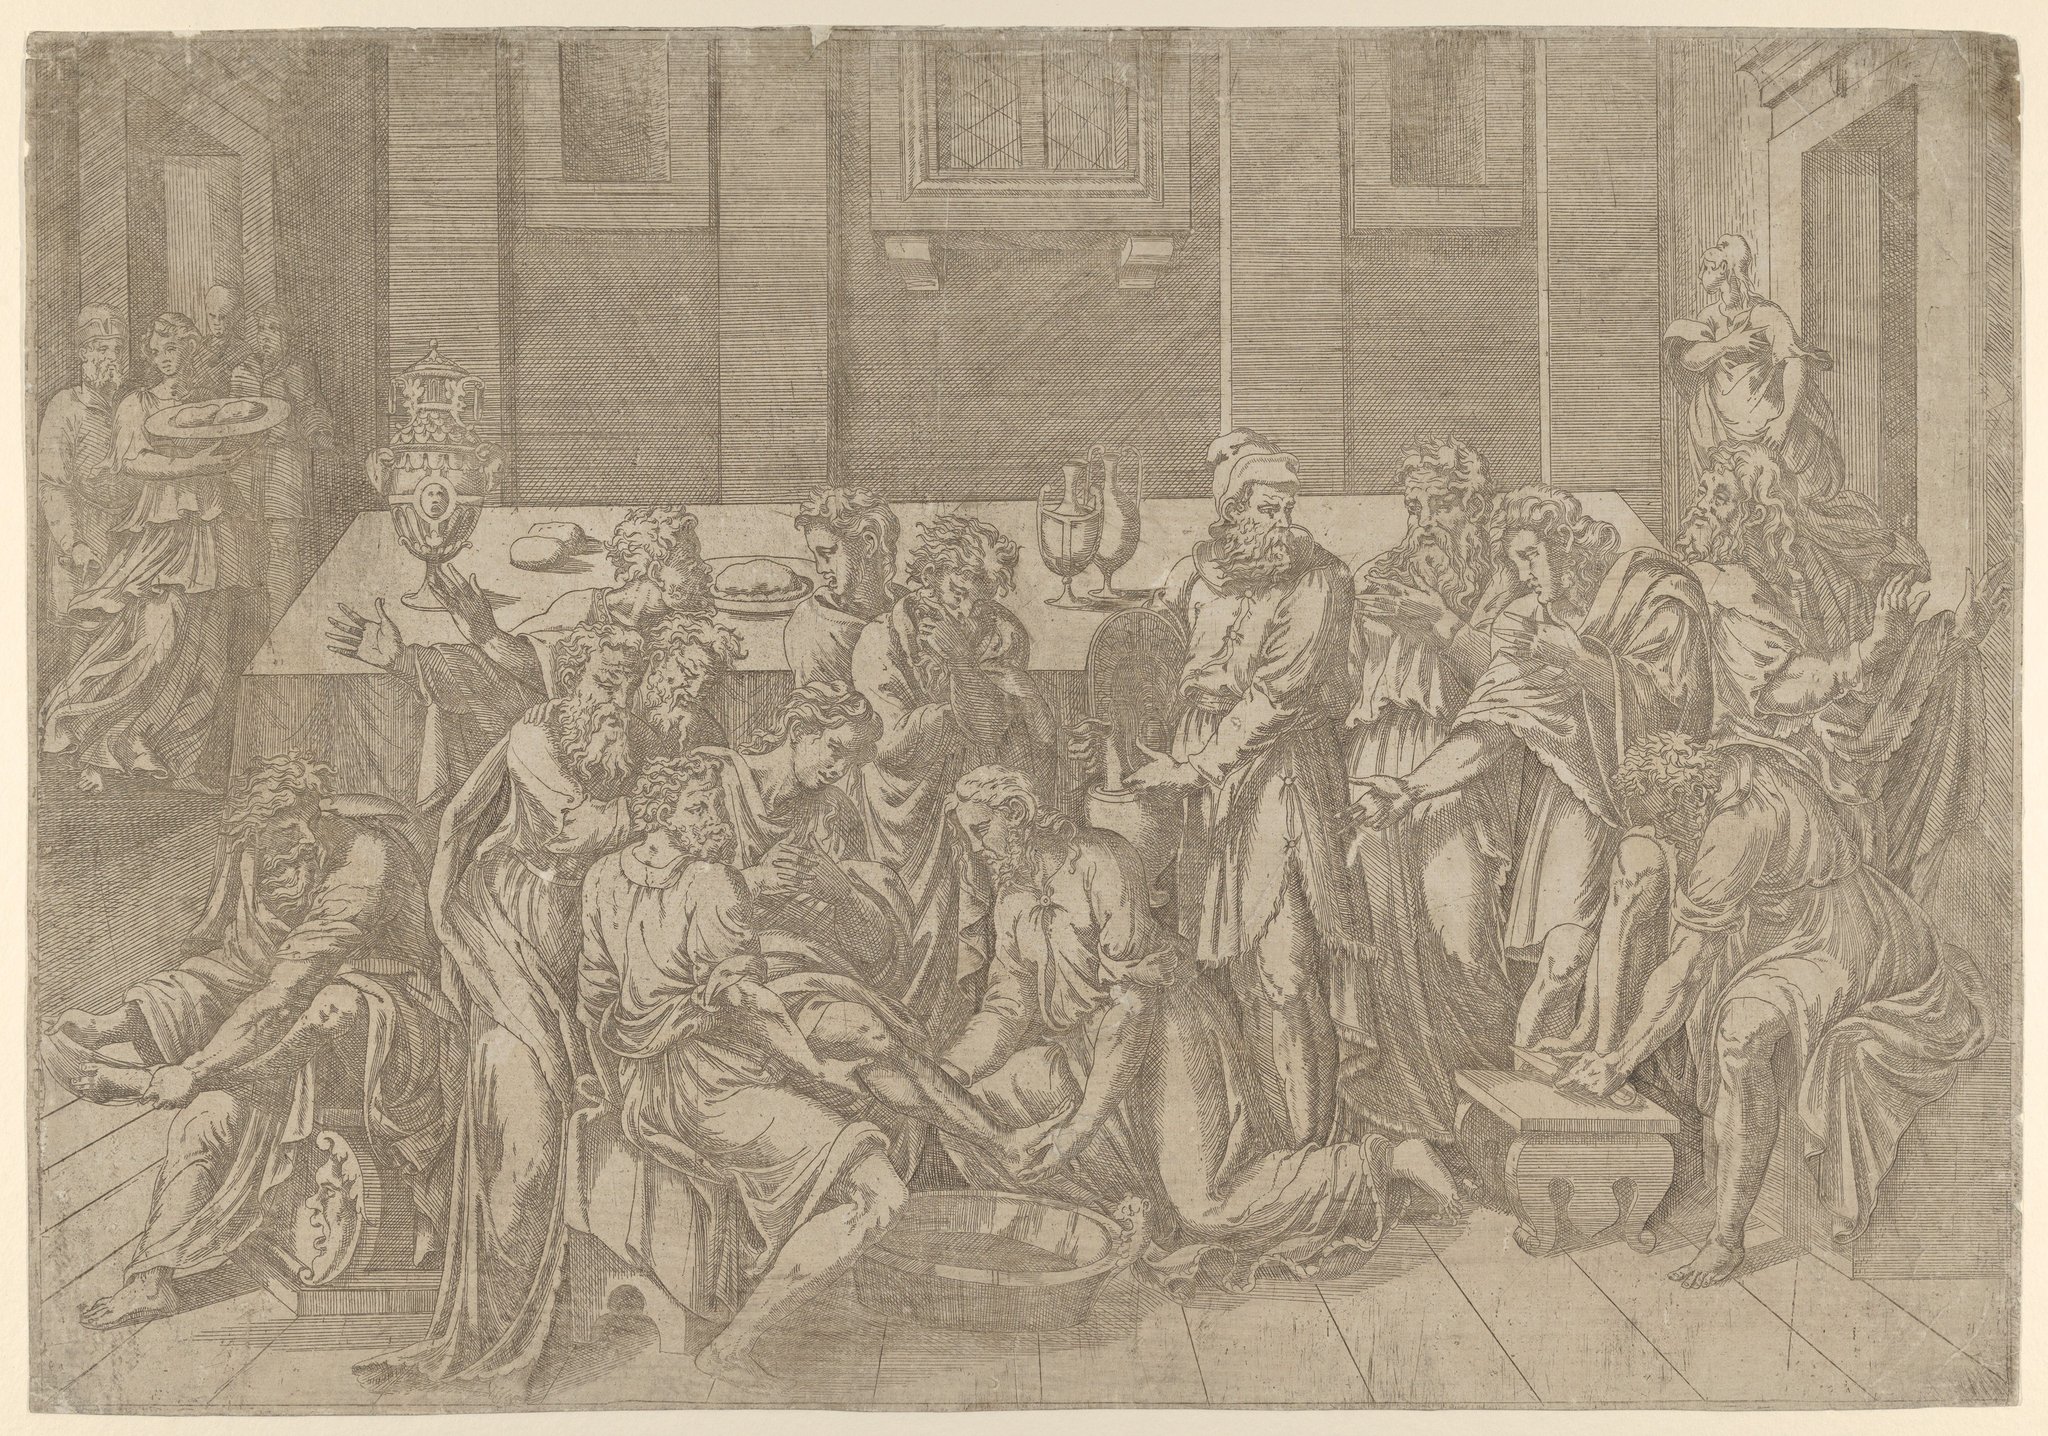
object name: print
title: Christ Washing the Feet of his Disciples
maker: antonio fantuzzi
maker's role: artist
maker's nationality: italian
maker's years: 1537-1545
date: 1540-1545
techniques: etching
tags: apostles,christ,washing